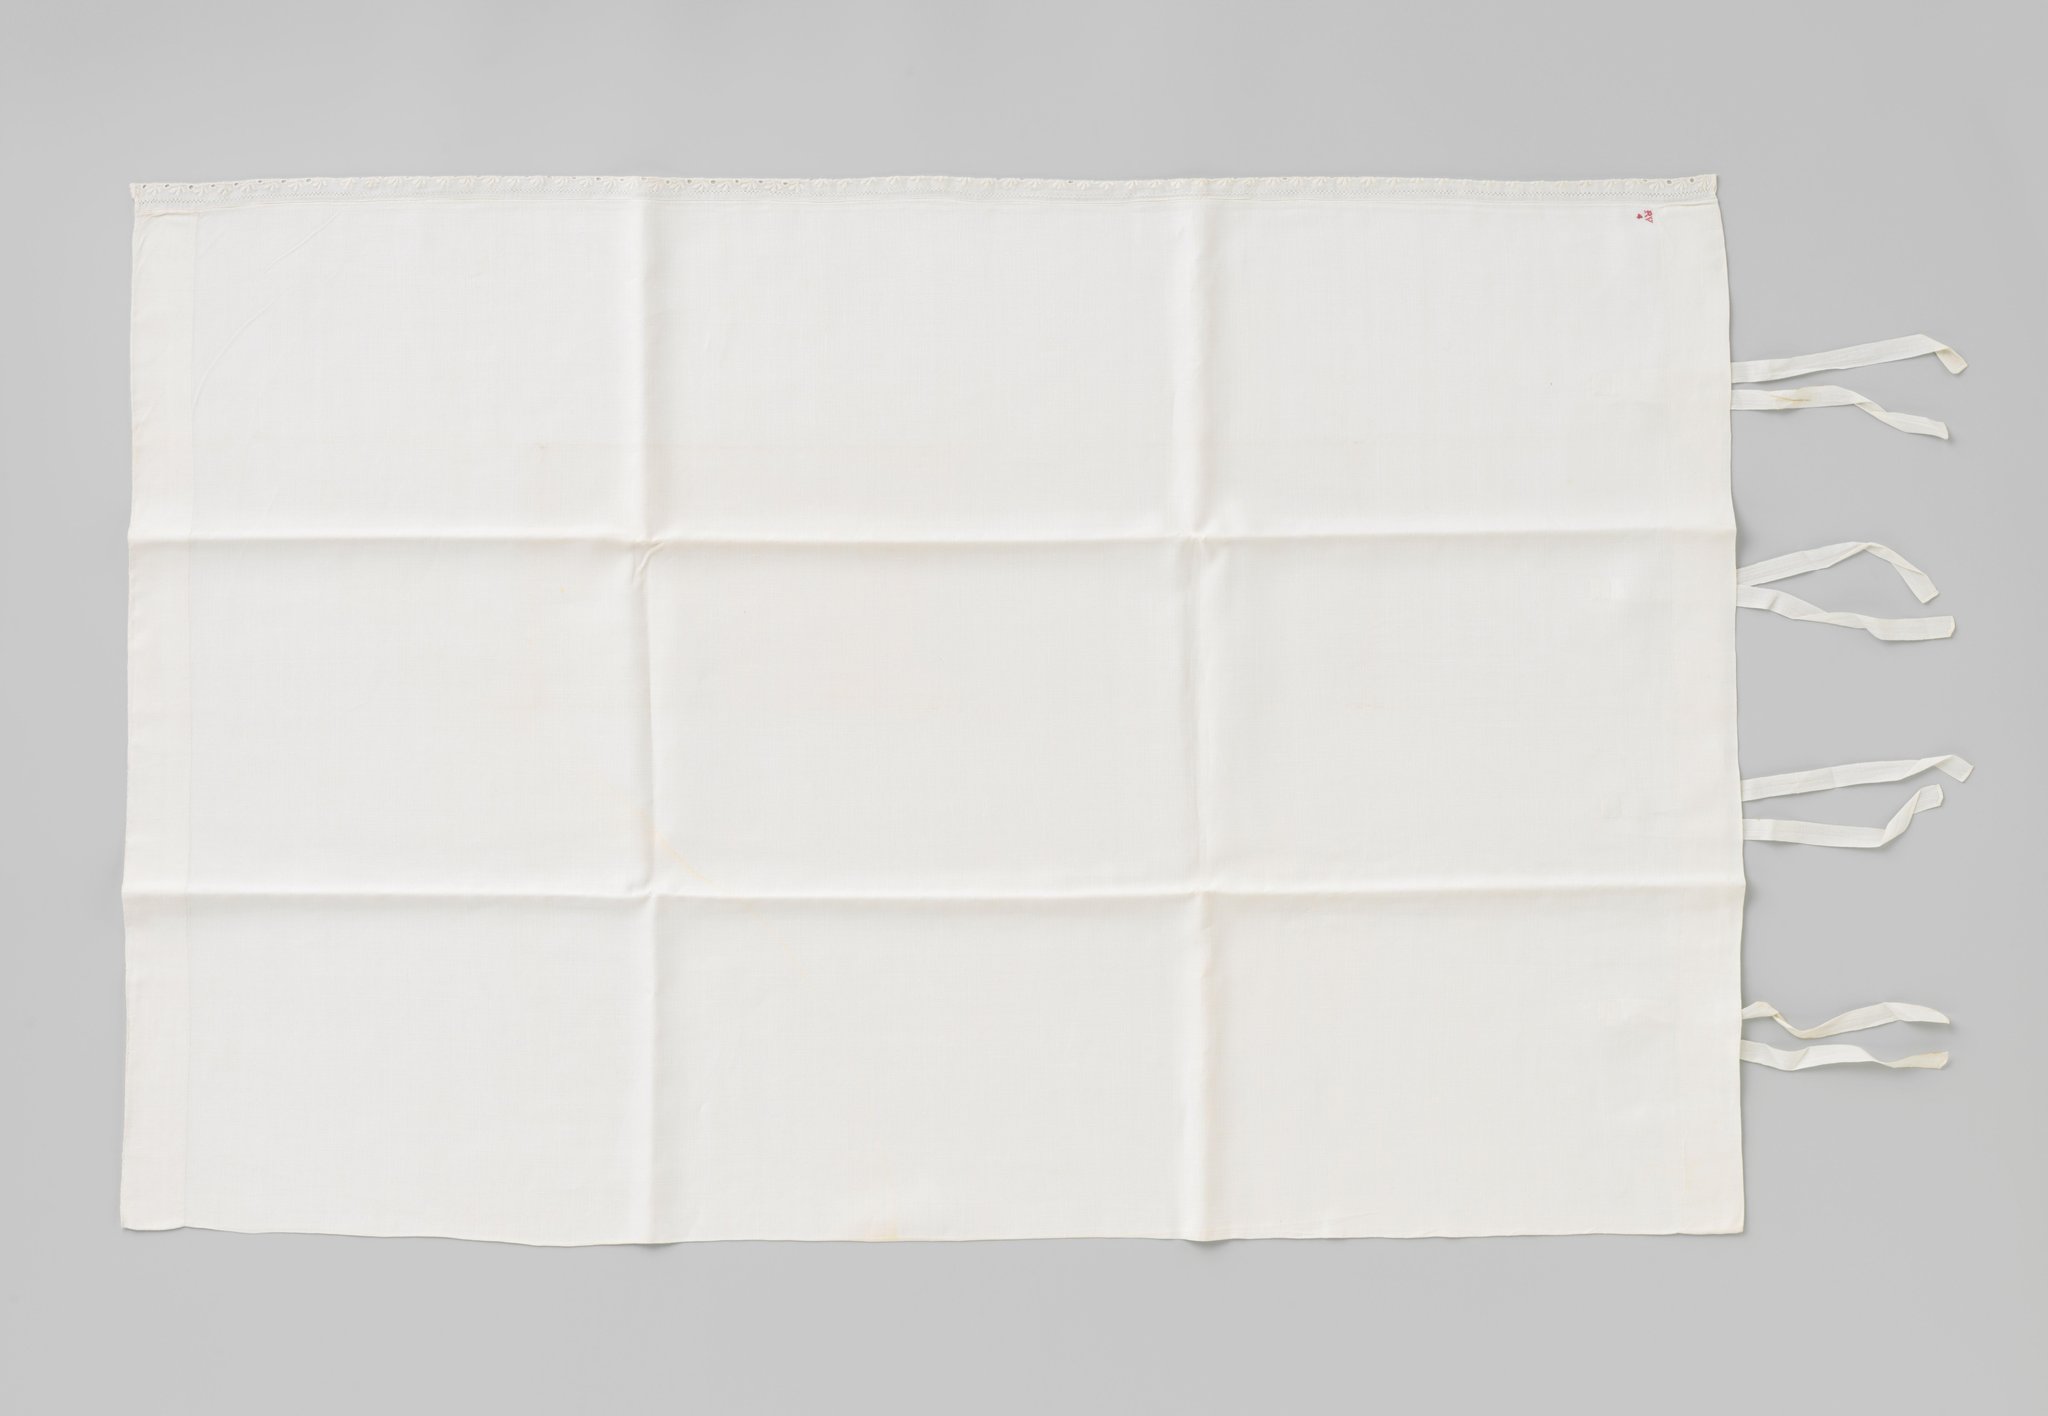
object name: sloop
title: Sloop van linnen met tussenzetsel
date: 1700-1800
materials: linen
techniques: cross stitching, embroidered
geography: netherlands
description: Sloop van linnen met tussenzetsel van wit opengewerkt borduurwerk uit de 2oste eeuw. Gemerkt in rode kruissteek: RV 4 (v.d.Ven).